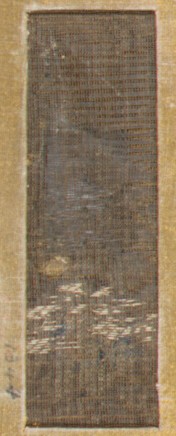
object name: piece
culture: japanese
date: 1701-1900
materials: silk